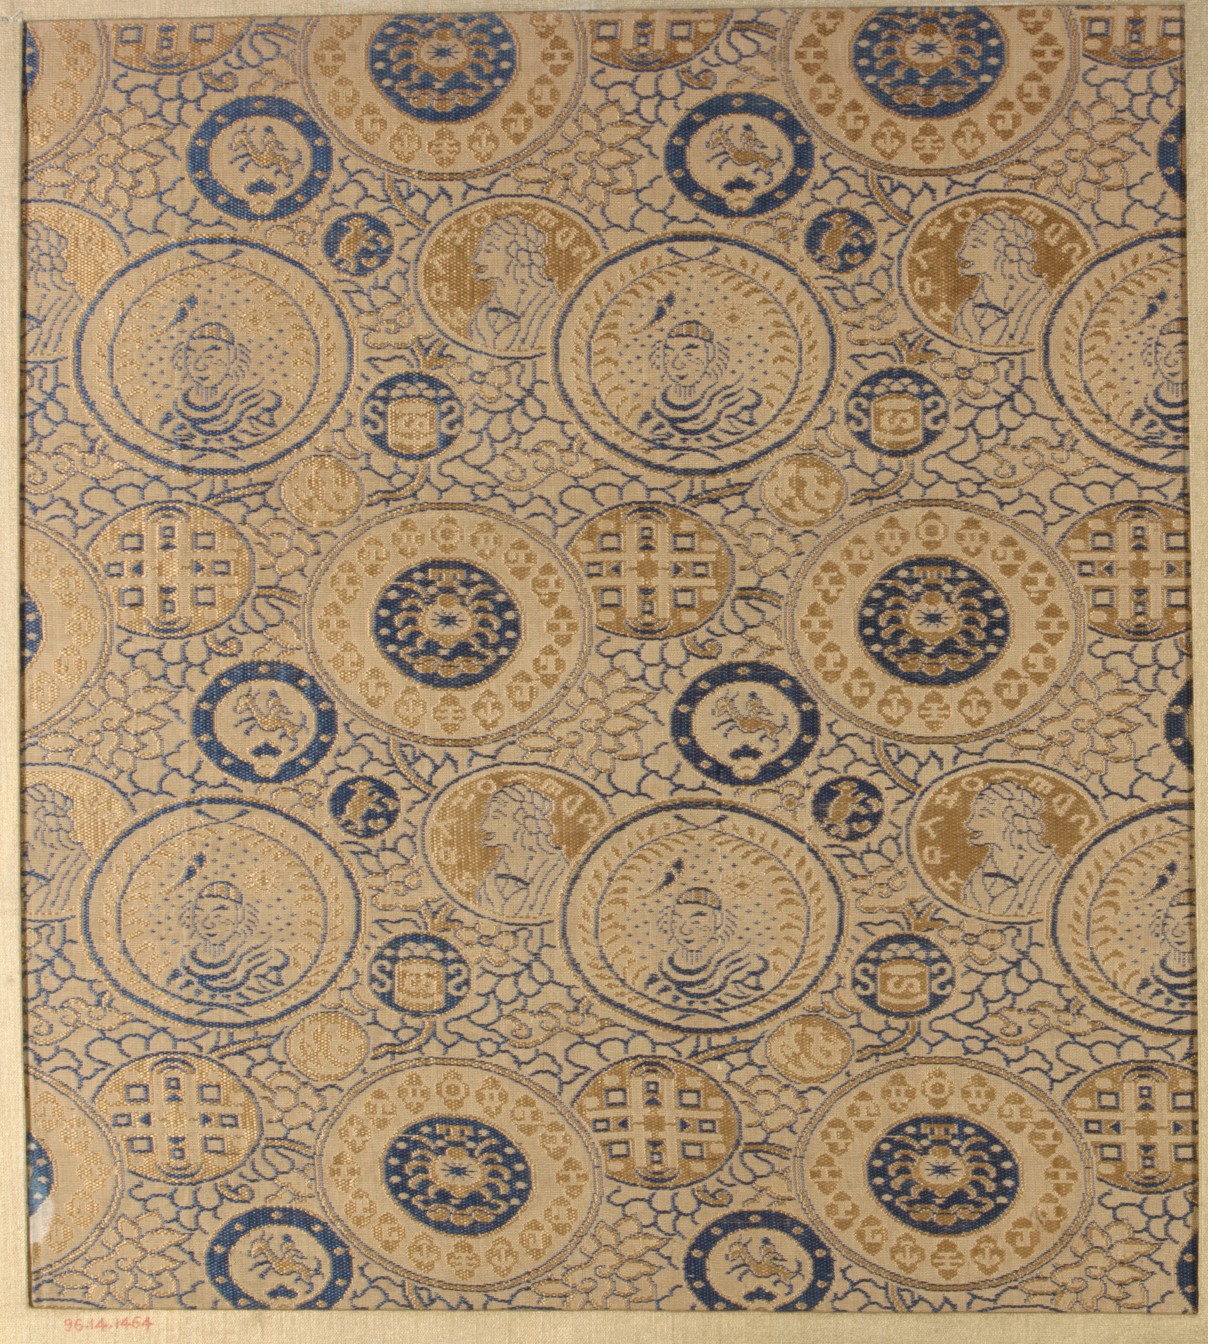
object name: piece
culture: japanese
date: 1701-1900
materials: silk